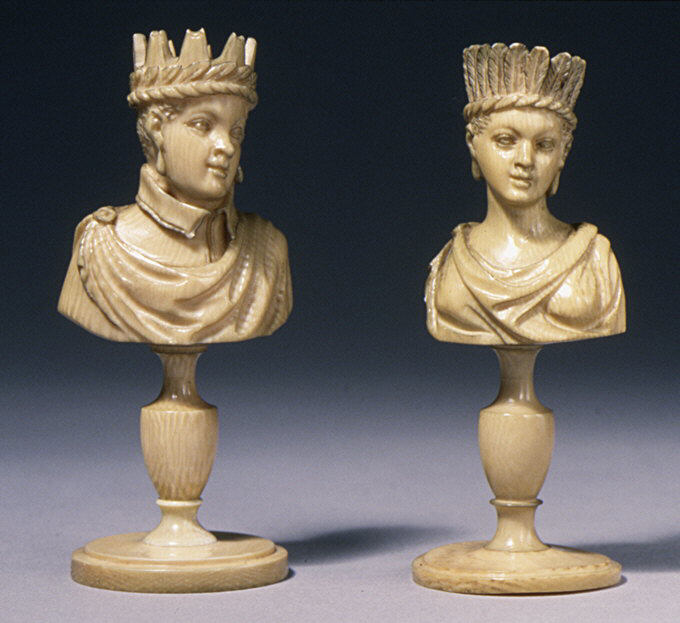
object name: chessman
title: Chessmen (32)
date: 1801-1900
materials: ivory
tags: men,women,chess